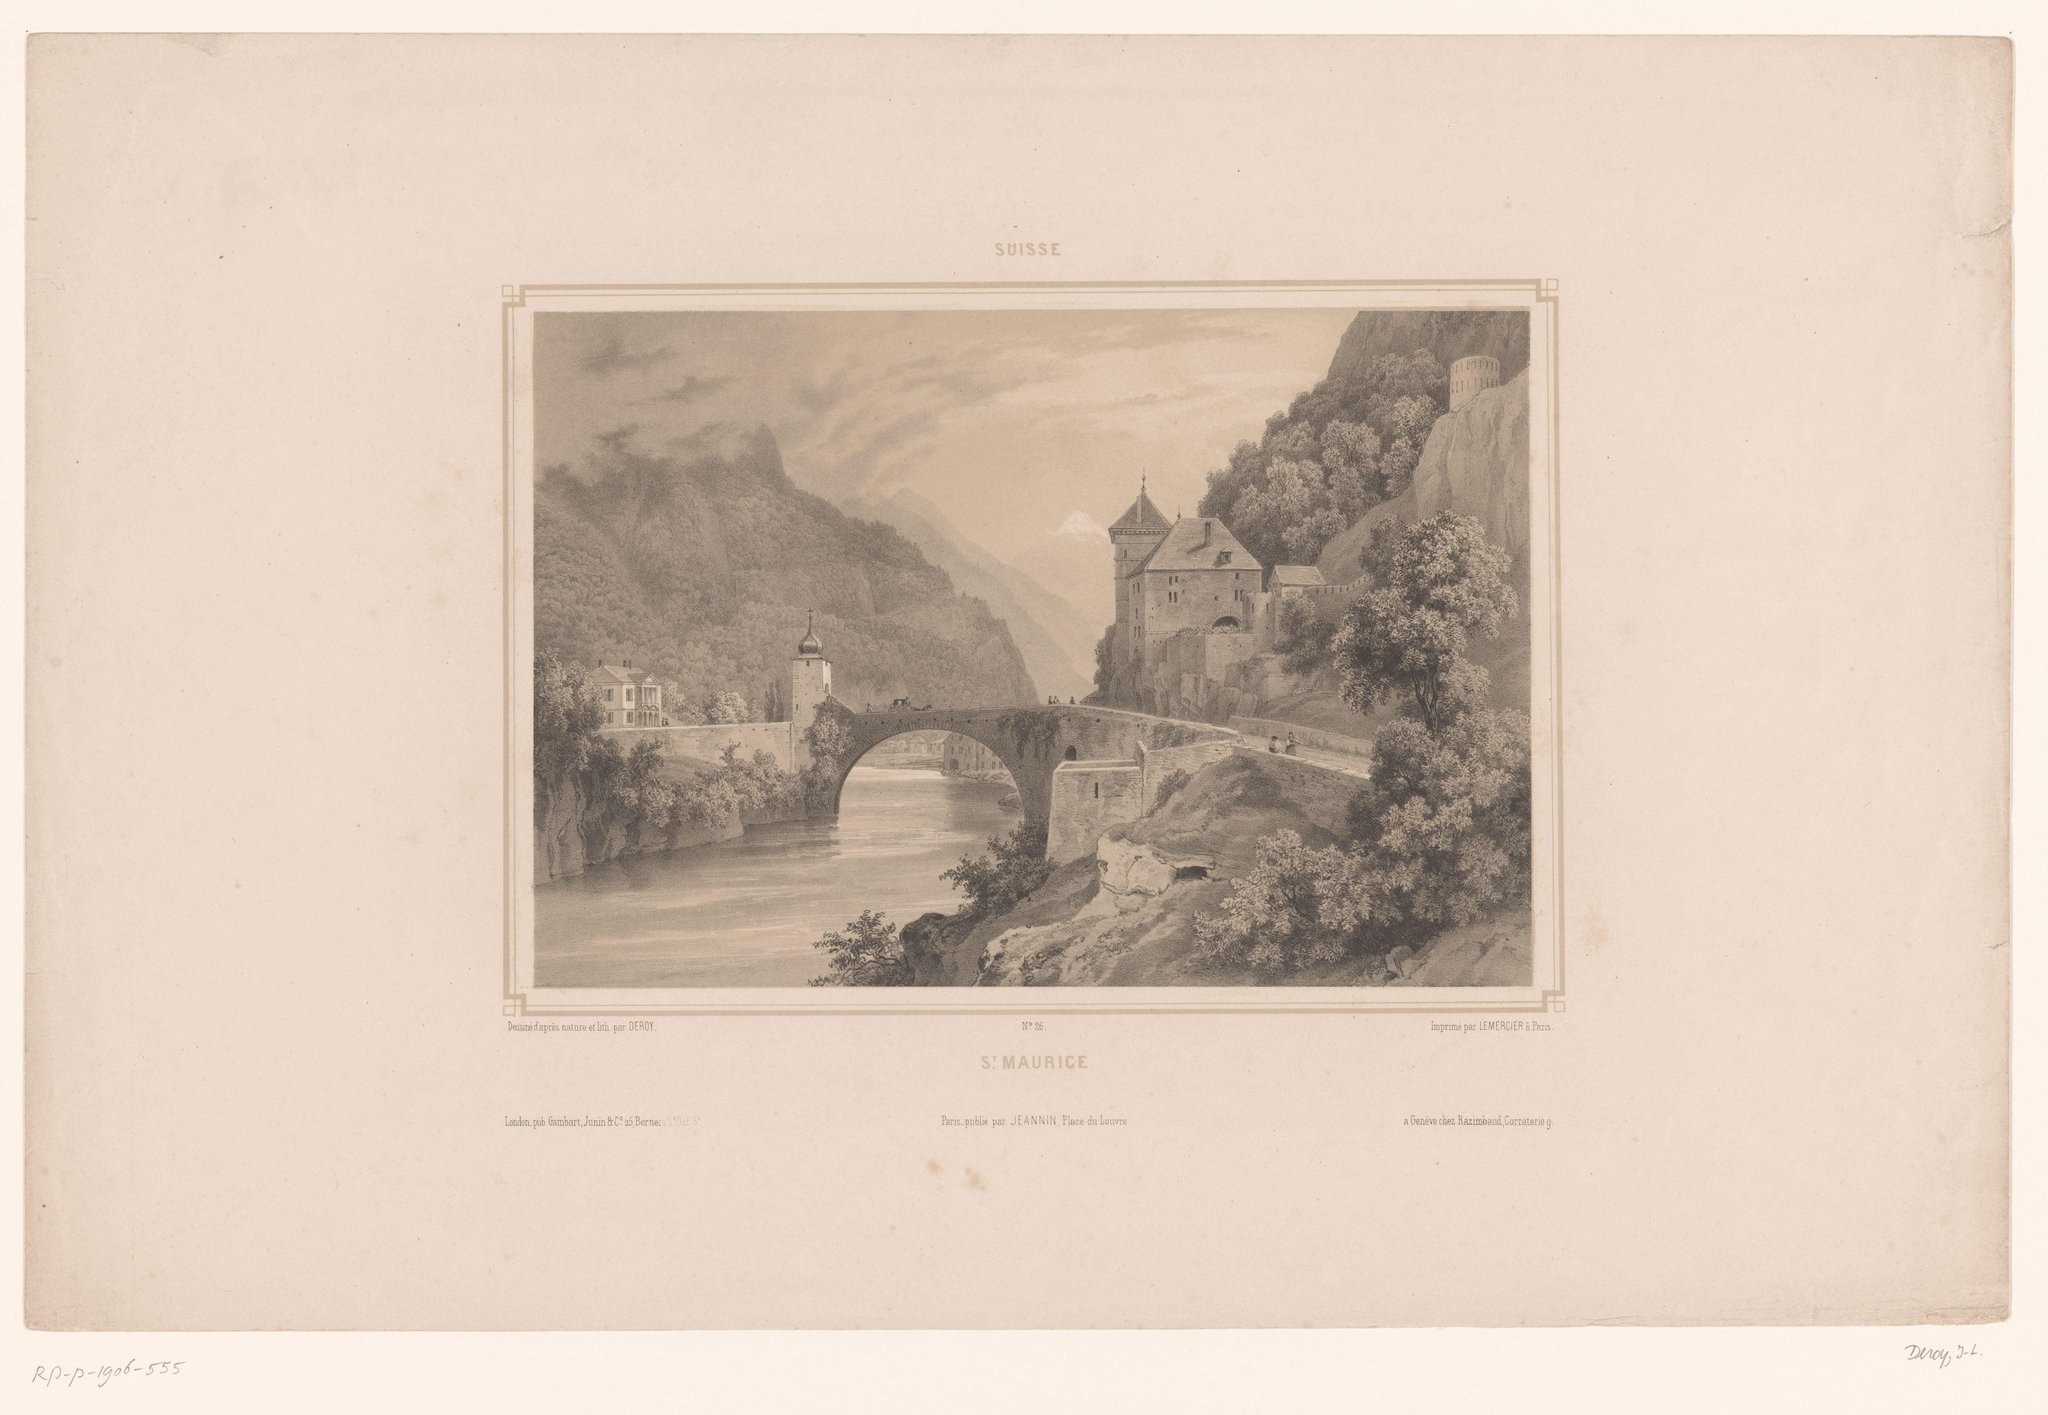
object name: print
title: Suisse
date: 1845-1851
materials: paper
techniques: tone lithography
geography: paris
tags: castle, mountains (+ landscape with figures, staffage), bridge in city across river, canal, etc., river (+ landscape with figures, staffage), prospect of village, silhouette of village (+ city(-scape) with figures, staffage)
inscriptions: collector's mark: Lugt 2228a, check stamp: Lugt 1397c